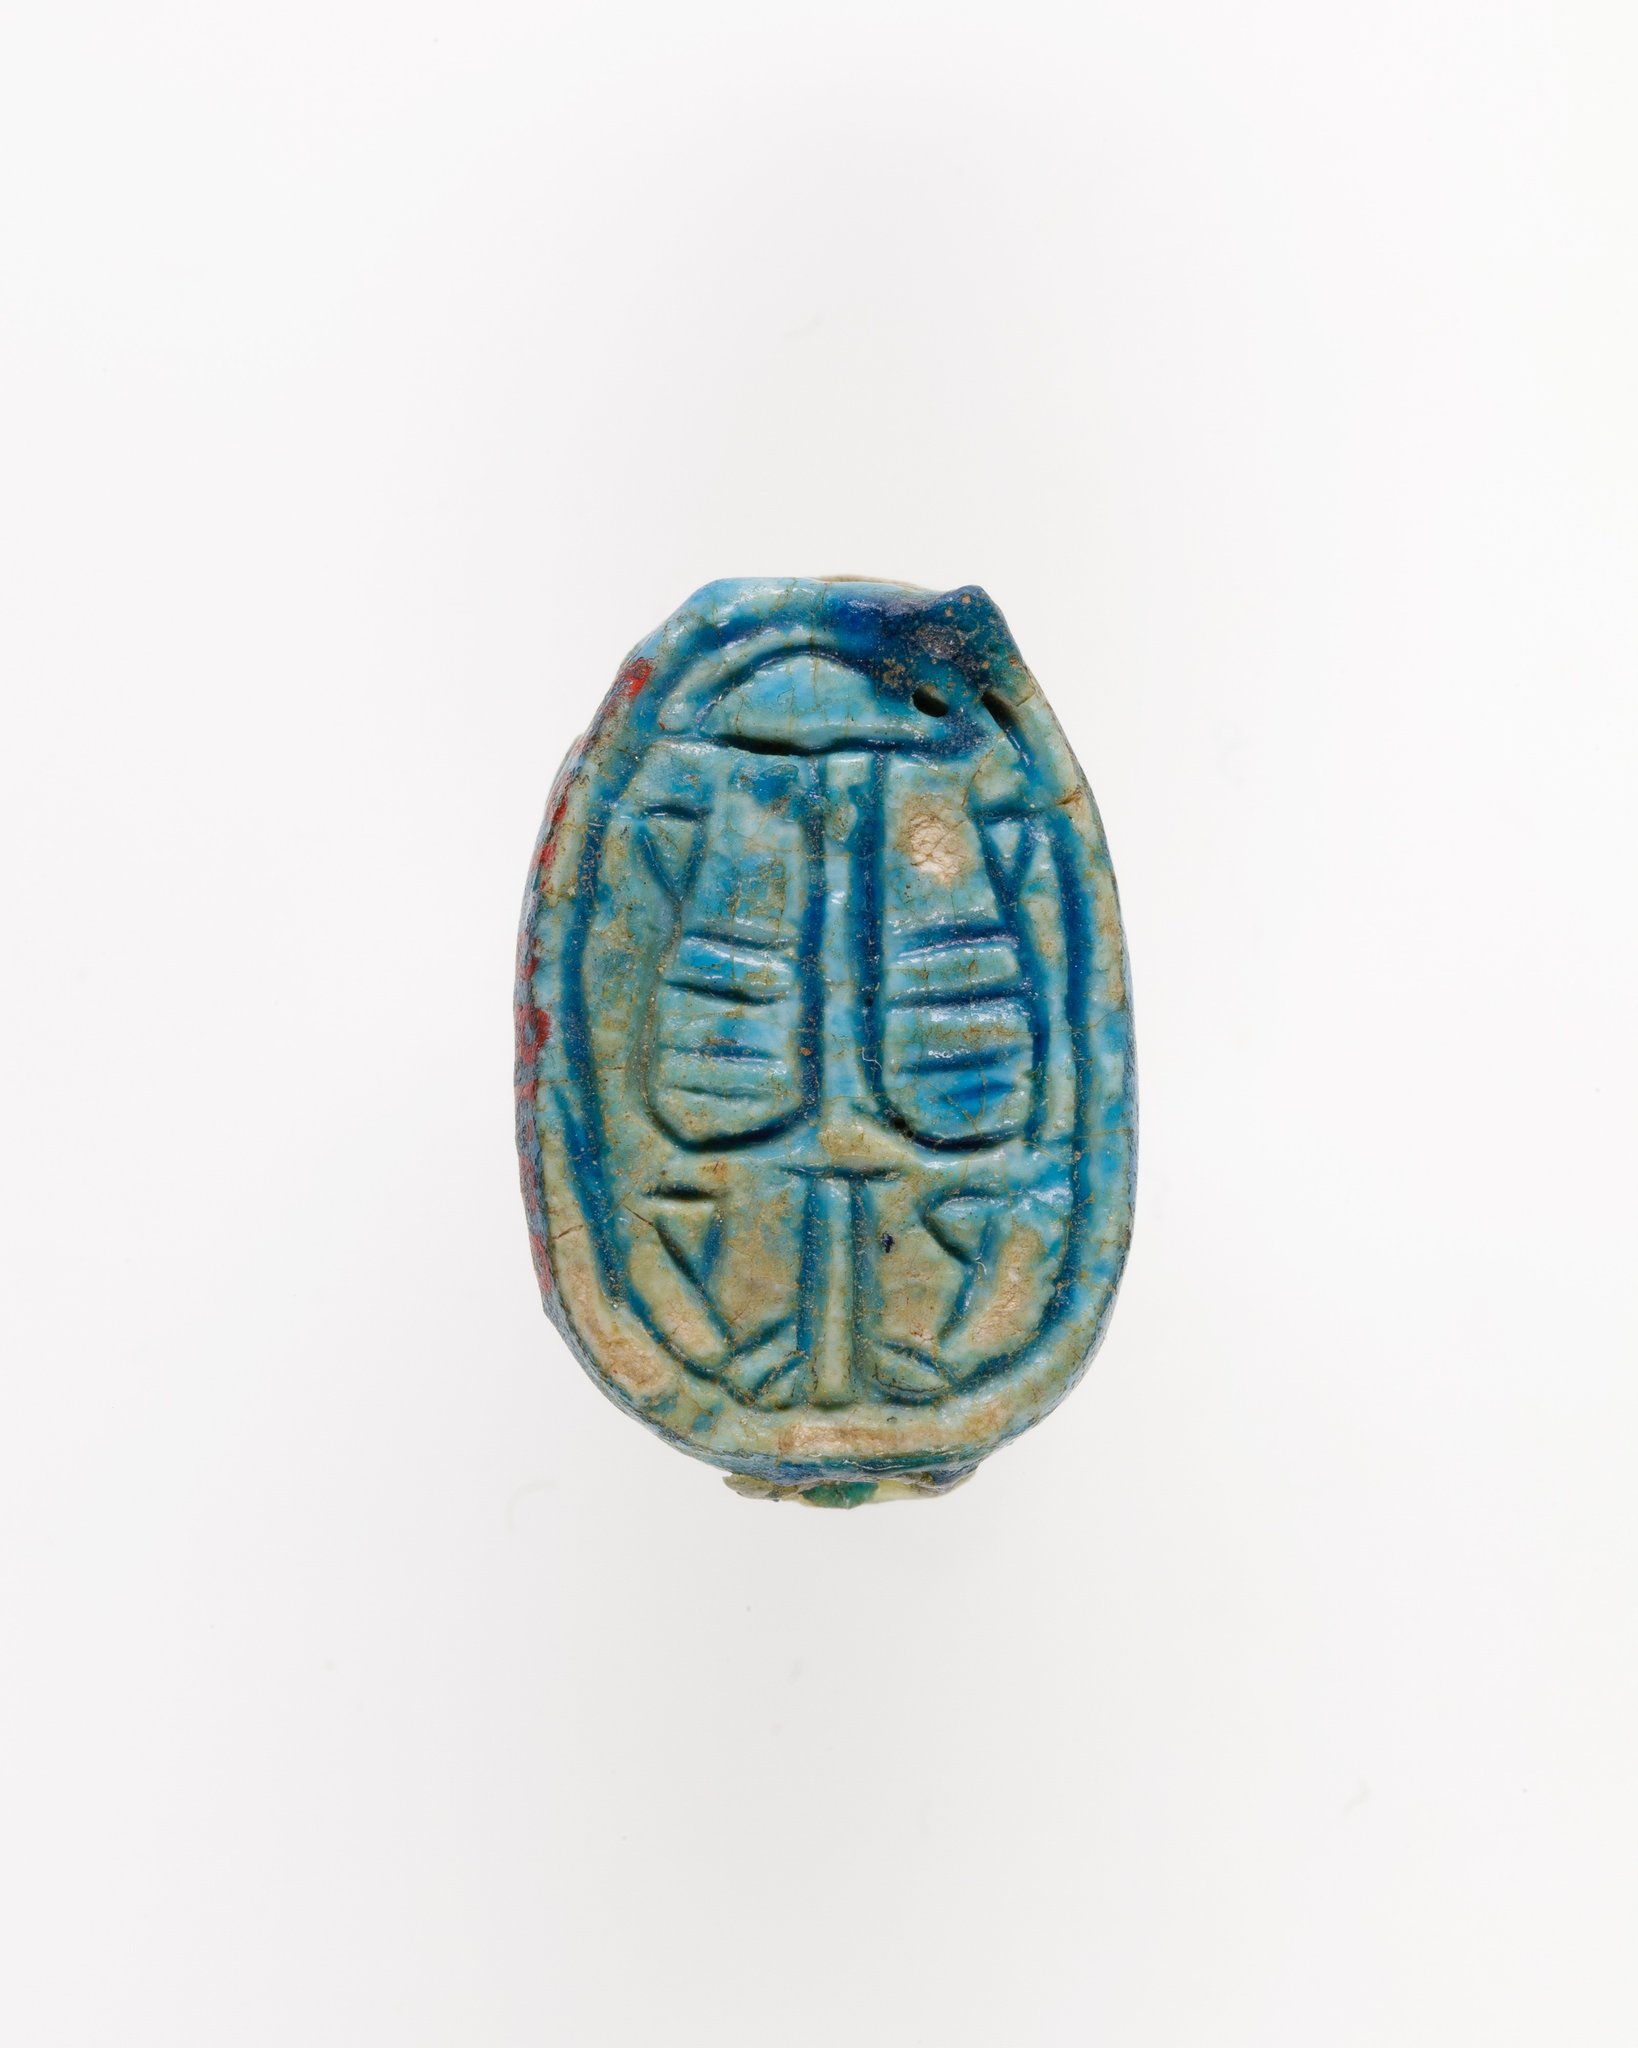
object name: scarab, papyrus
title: Scarab with Papryus Plant Decoration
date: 1850-1640 BCE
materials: stone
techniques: glazing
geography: egypt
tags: hieroglyphs,scarabs